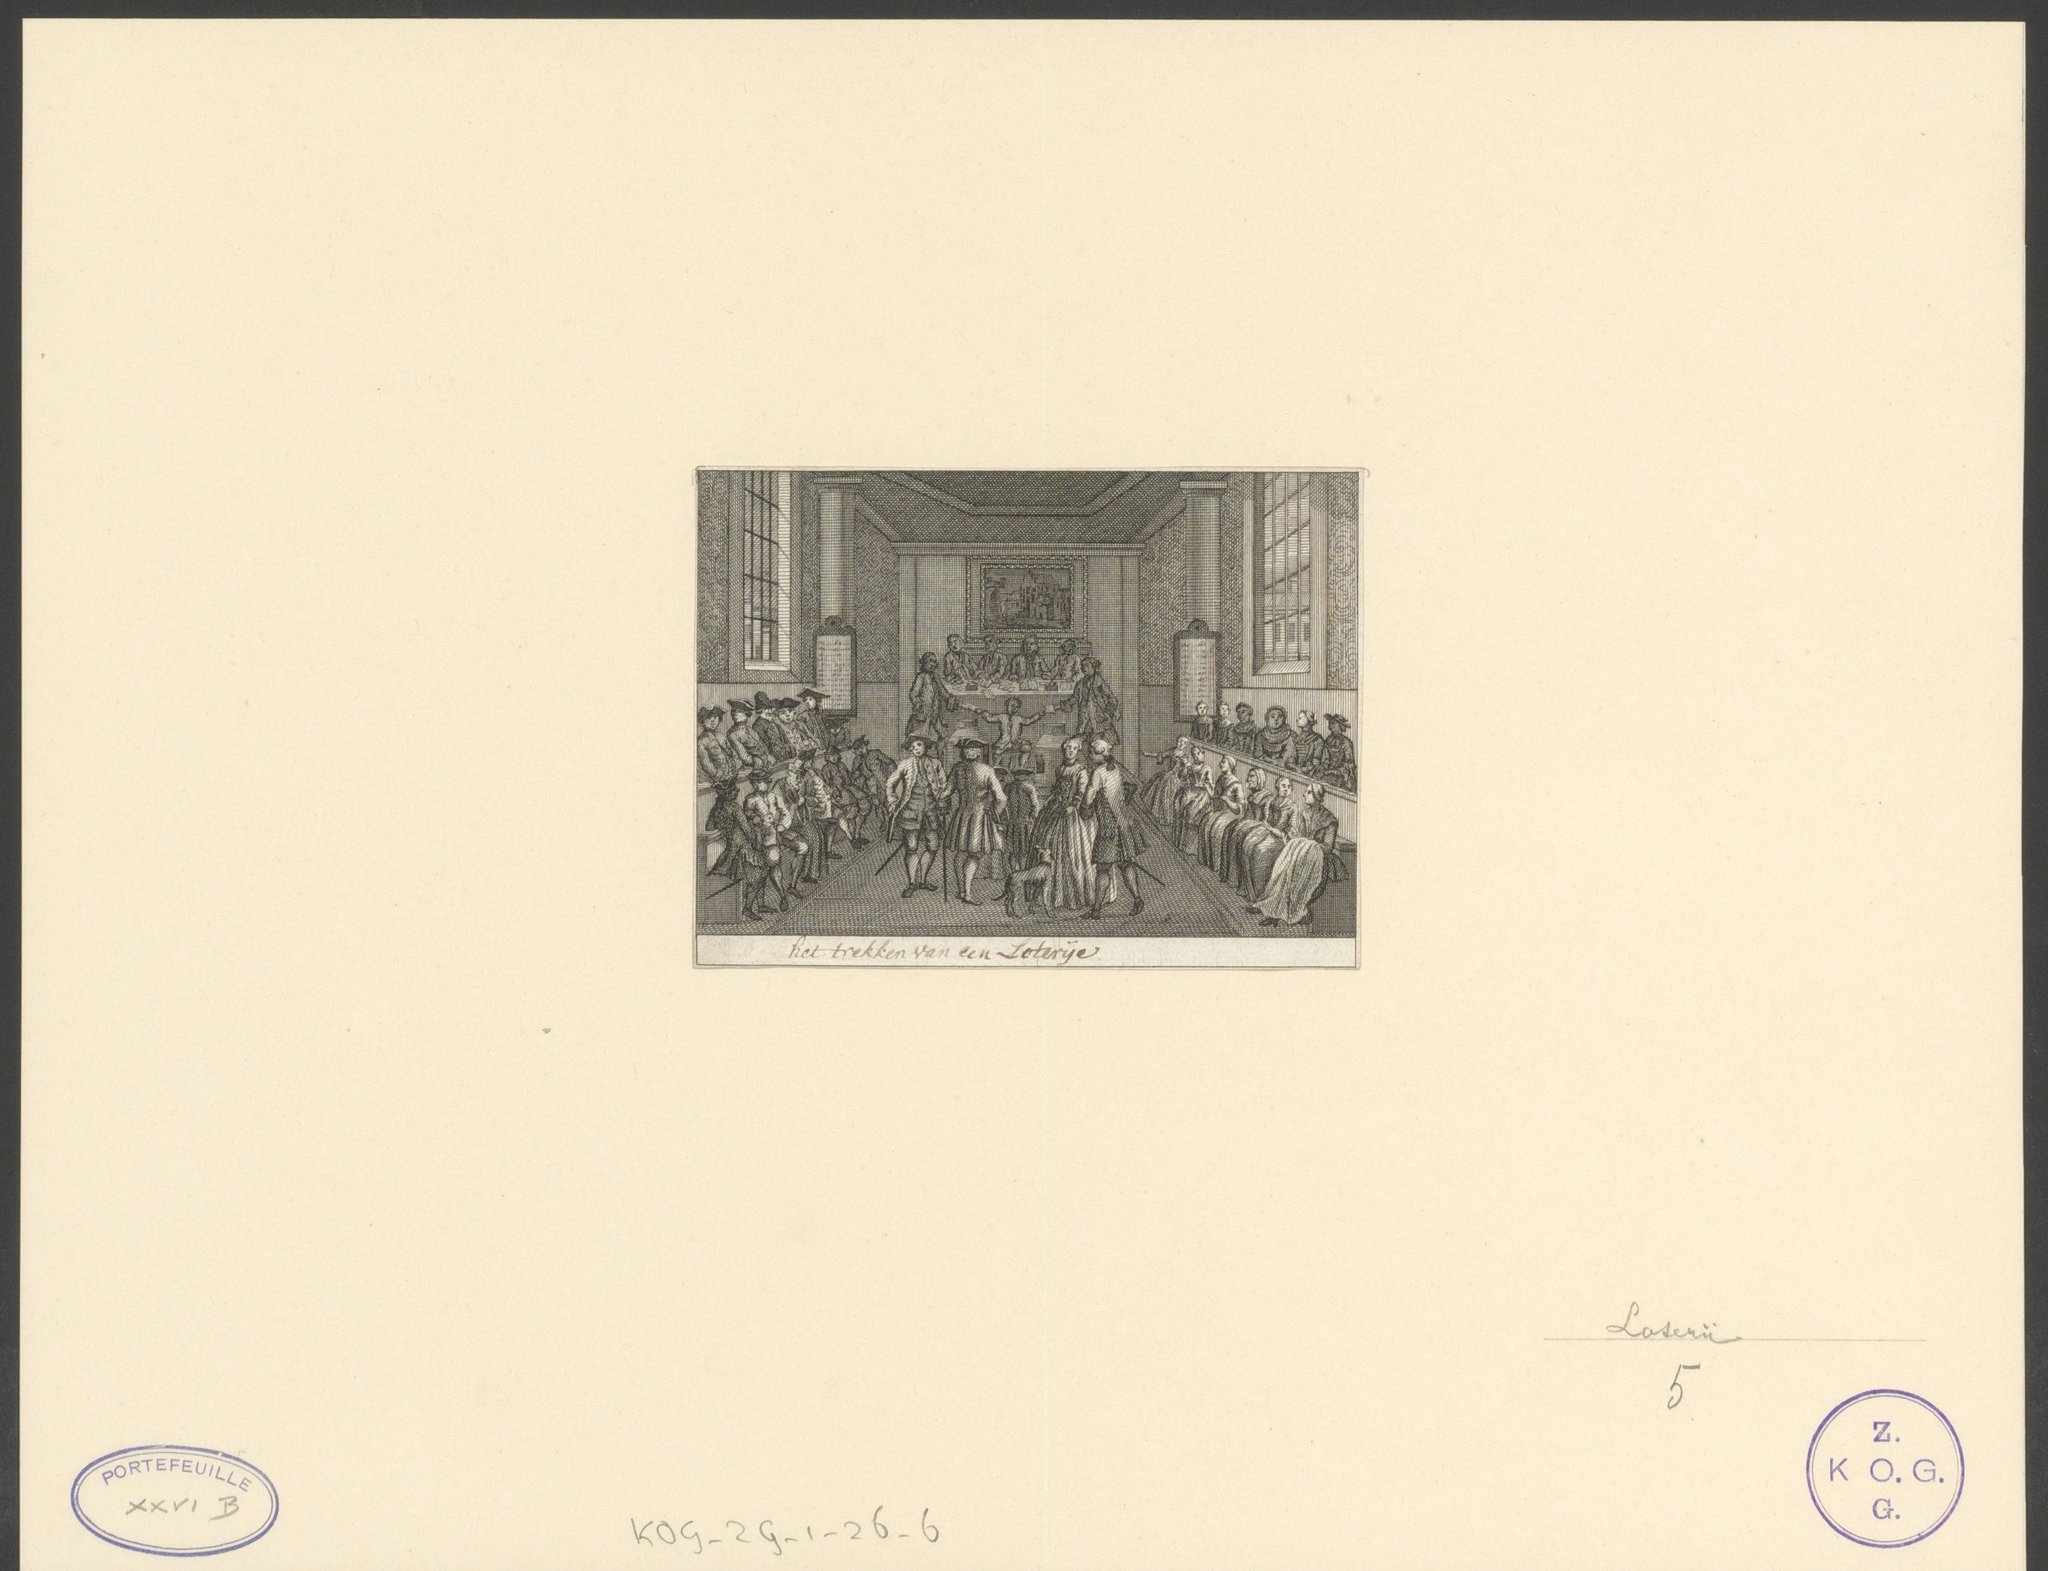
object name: print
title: Het trekken van een loterije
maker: Anonymous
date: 1750-1820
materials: paper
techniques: etching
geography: netherlands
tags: raffle, lottery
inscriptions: collector's mark, collector's mark: Lugt 1641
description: Een loterij in een interieur waarbij de loten uit twee bussen getrokken worden door een jongen. Mannen zitten links, vrouwen rechts. Onderwerpsrubrieken binnen de Atlas Zeden en Gewoonten: Spel en Vermaak; Loterij.